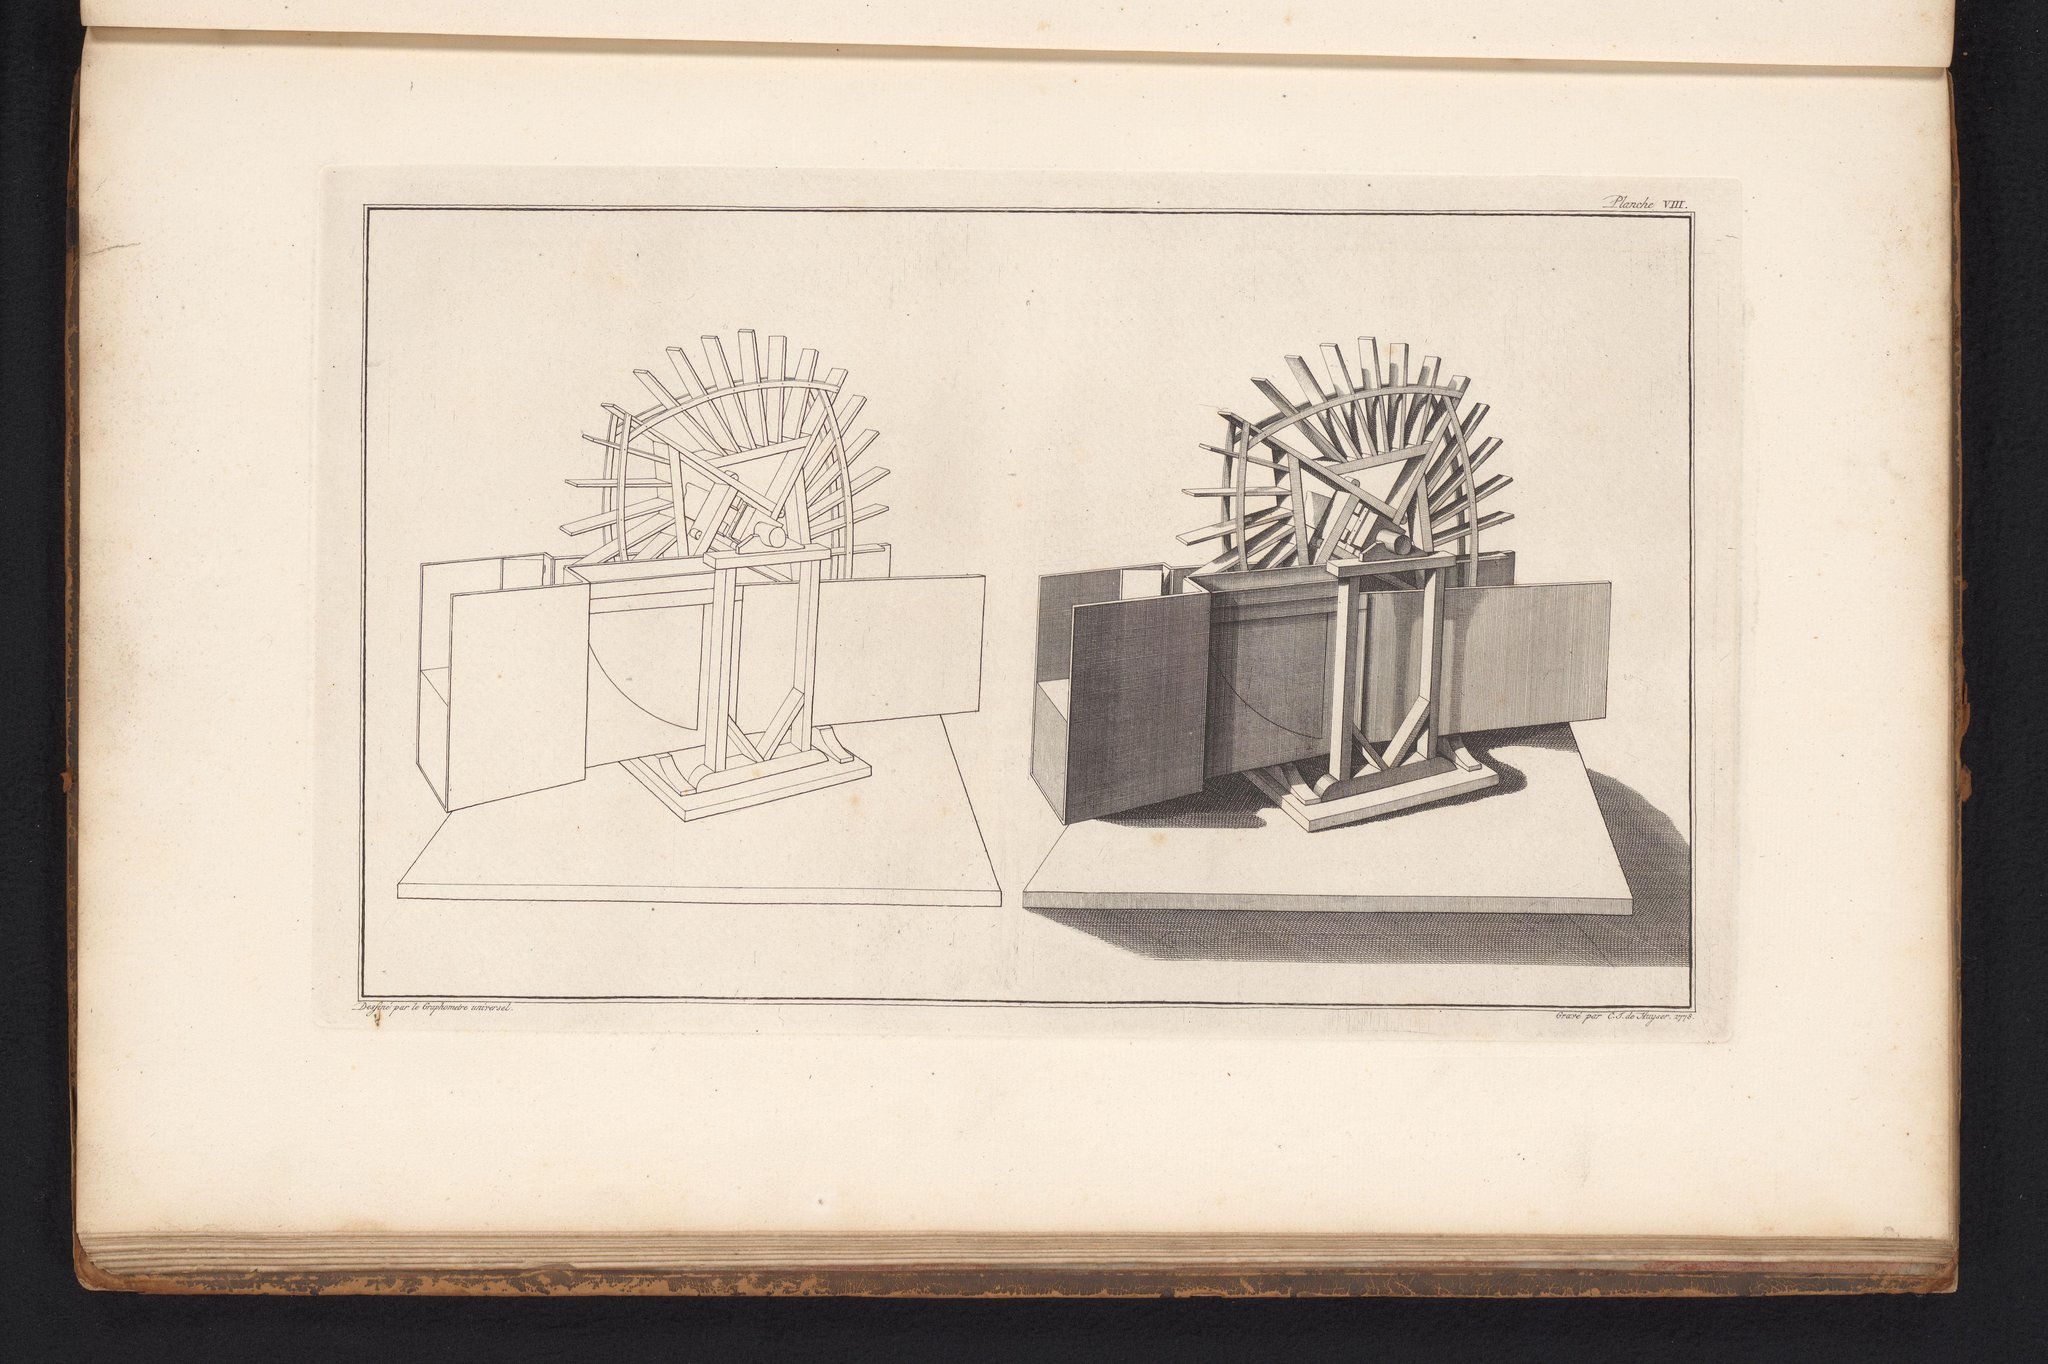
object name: album leaf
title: Beschryving van een' algemeenen graphometer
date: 1778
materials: paper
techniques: engraving, etching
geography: amsterdam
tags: instruments for perspective drawing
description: Een model van een waterscheprad, eerst in omtrek getekend met behulp van een grafometer. Rechtsboven gemerkt: Planche VIII. De prent maakt deel uit van het boek: A.G. Eckhardt, Beschryving van een algemeenen graphometer, 1778.